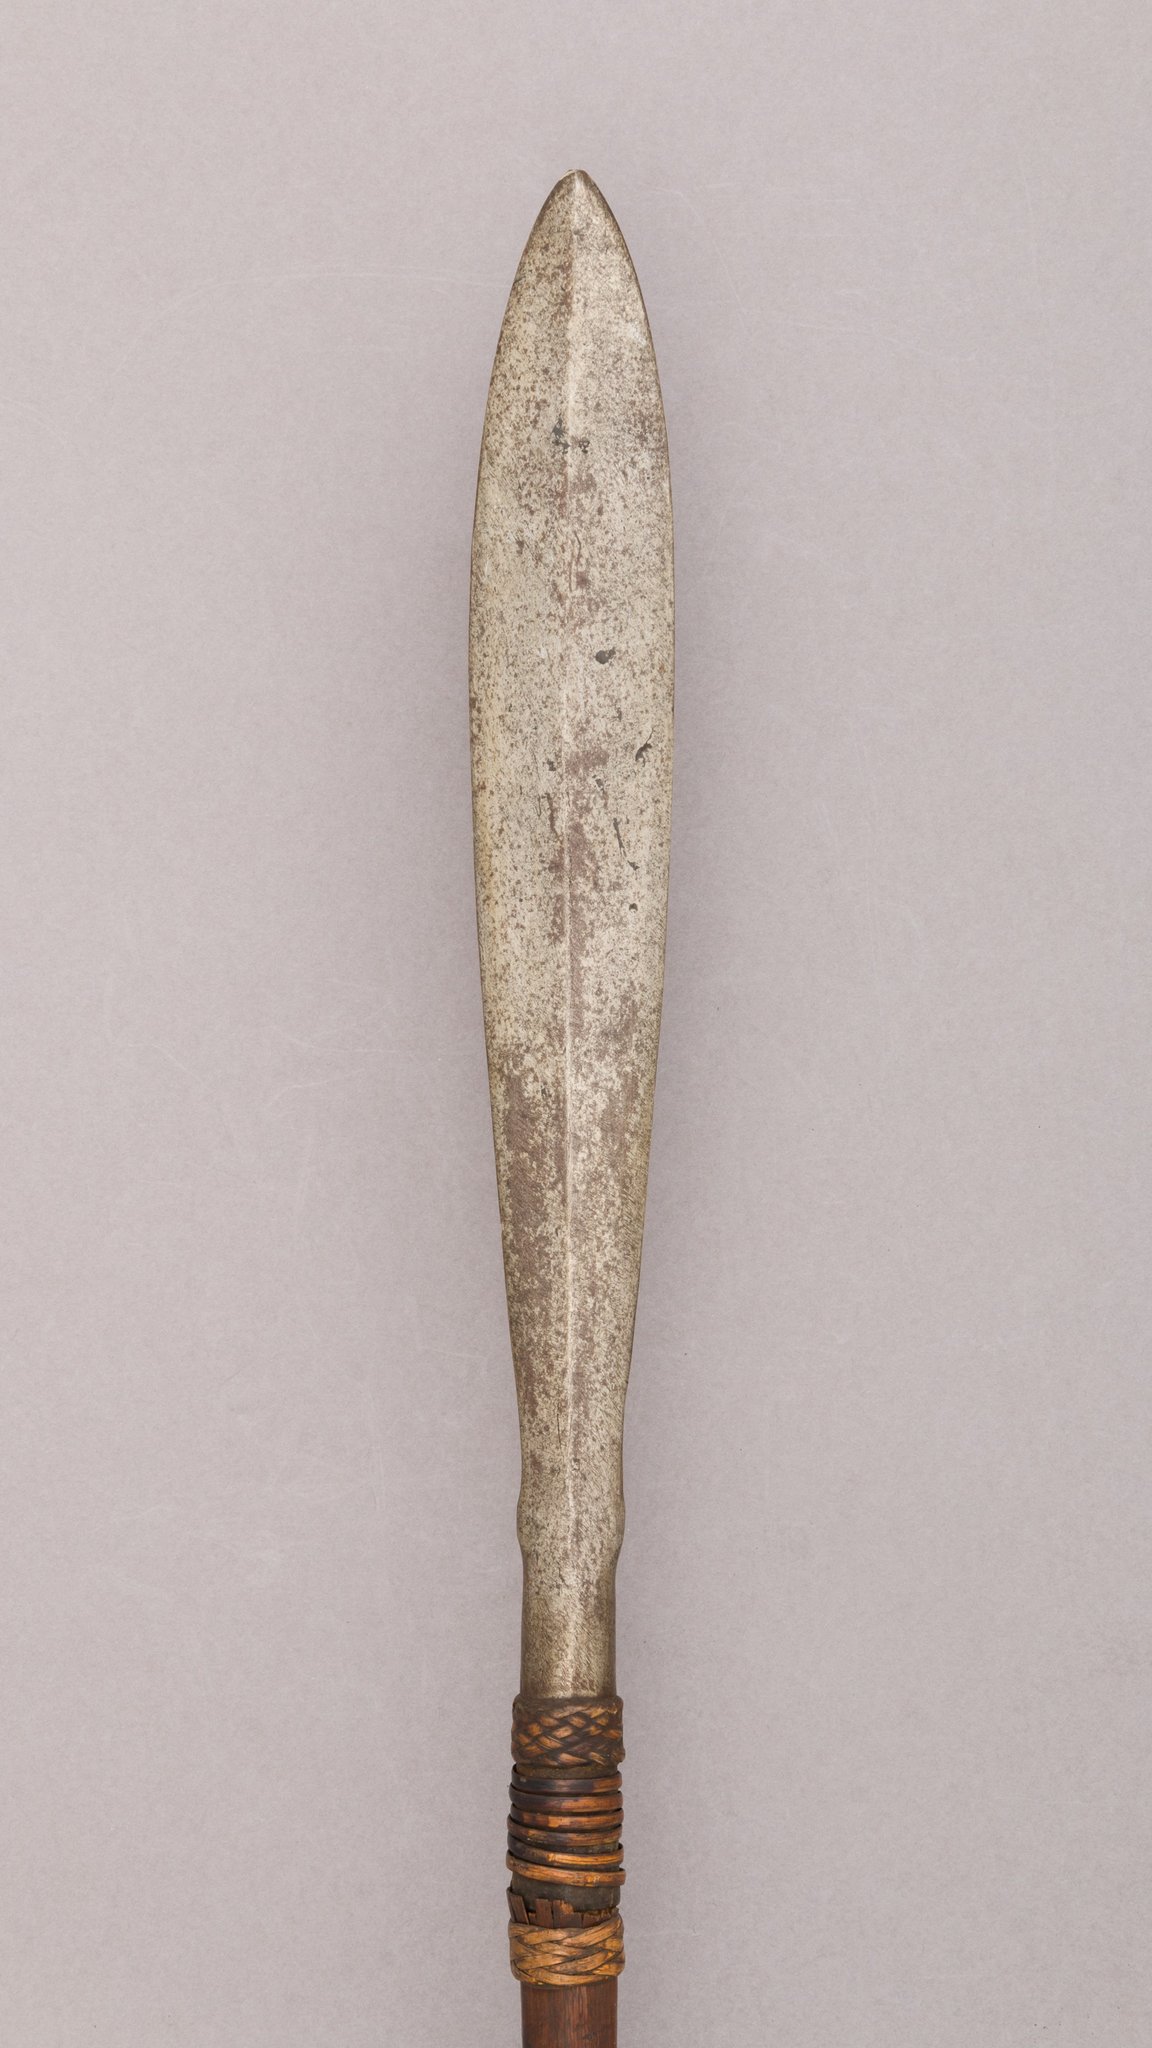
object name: spear fang kao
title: Spear (Fang-Kao)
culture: philippine or igorot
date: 1701-1900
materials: steel, wood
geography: philippines